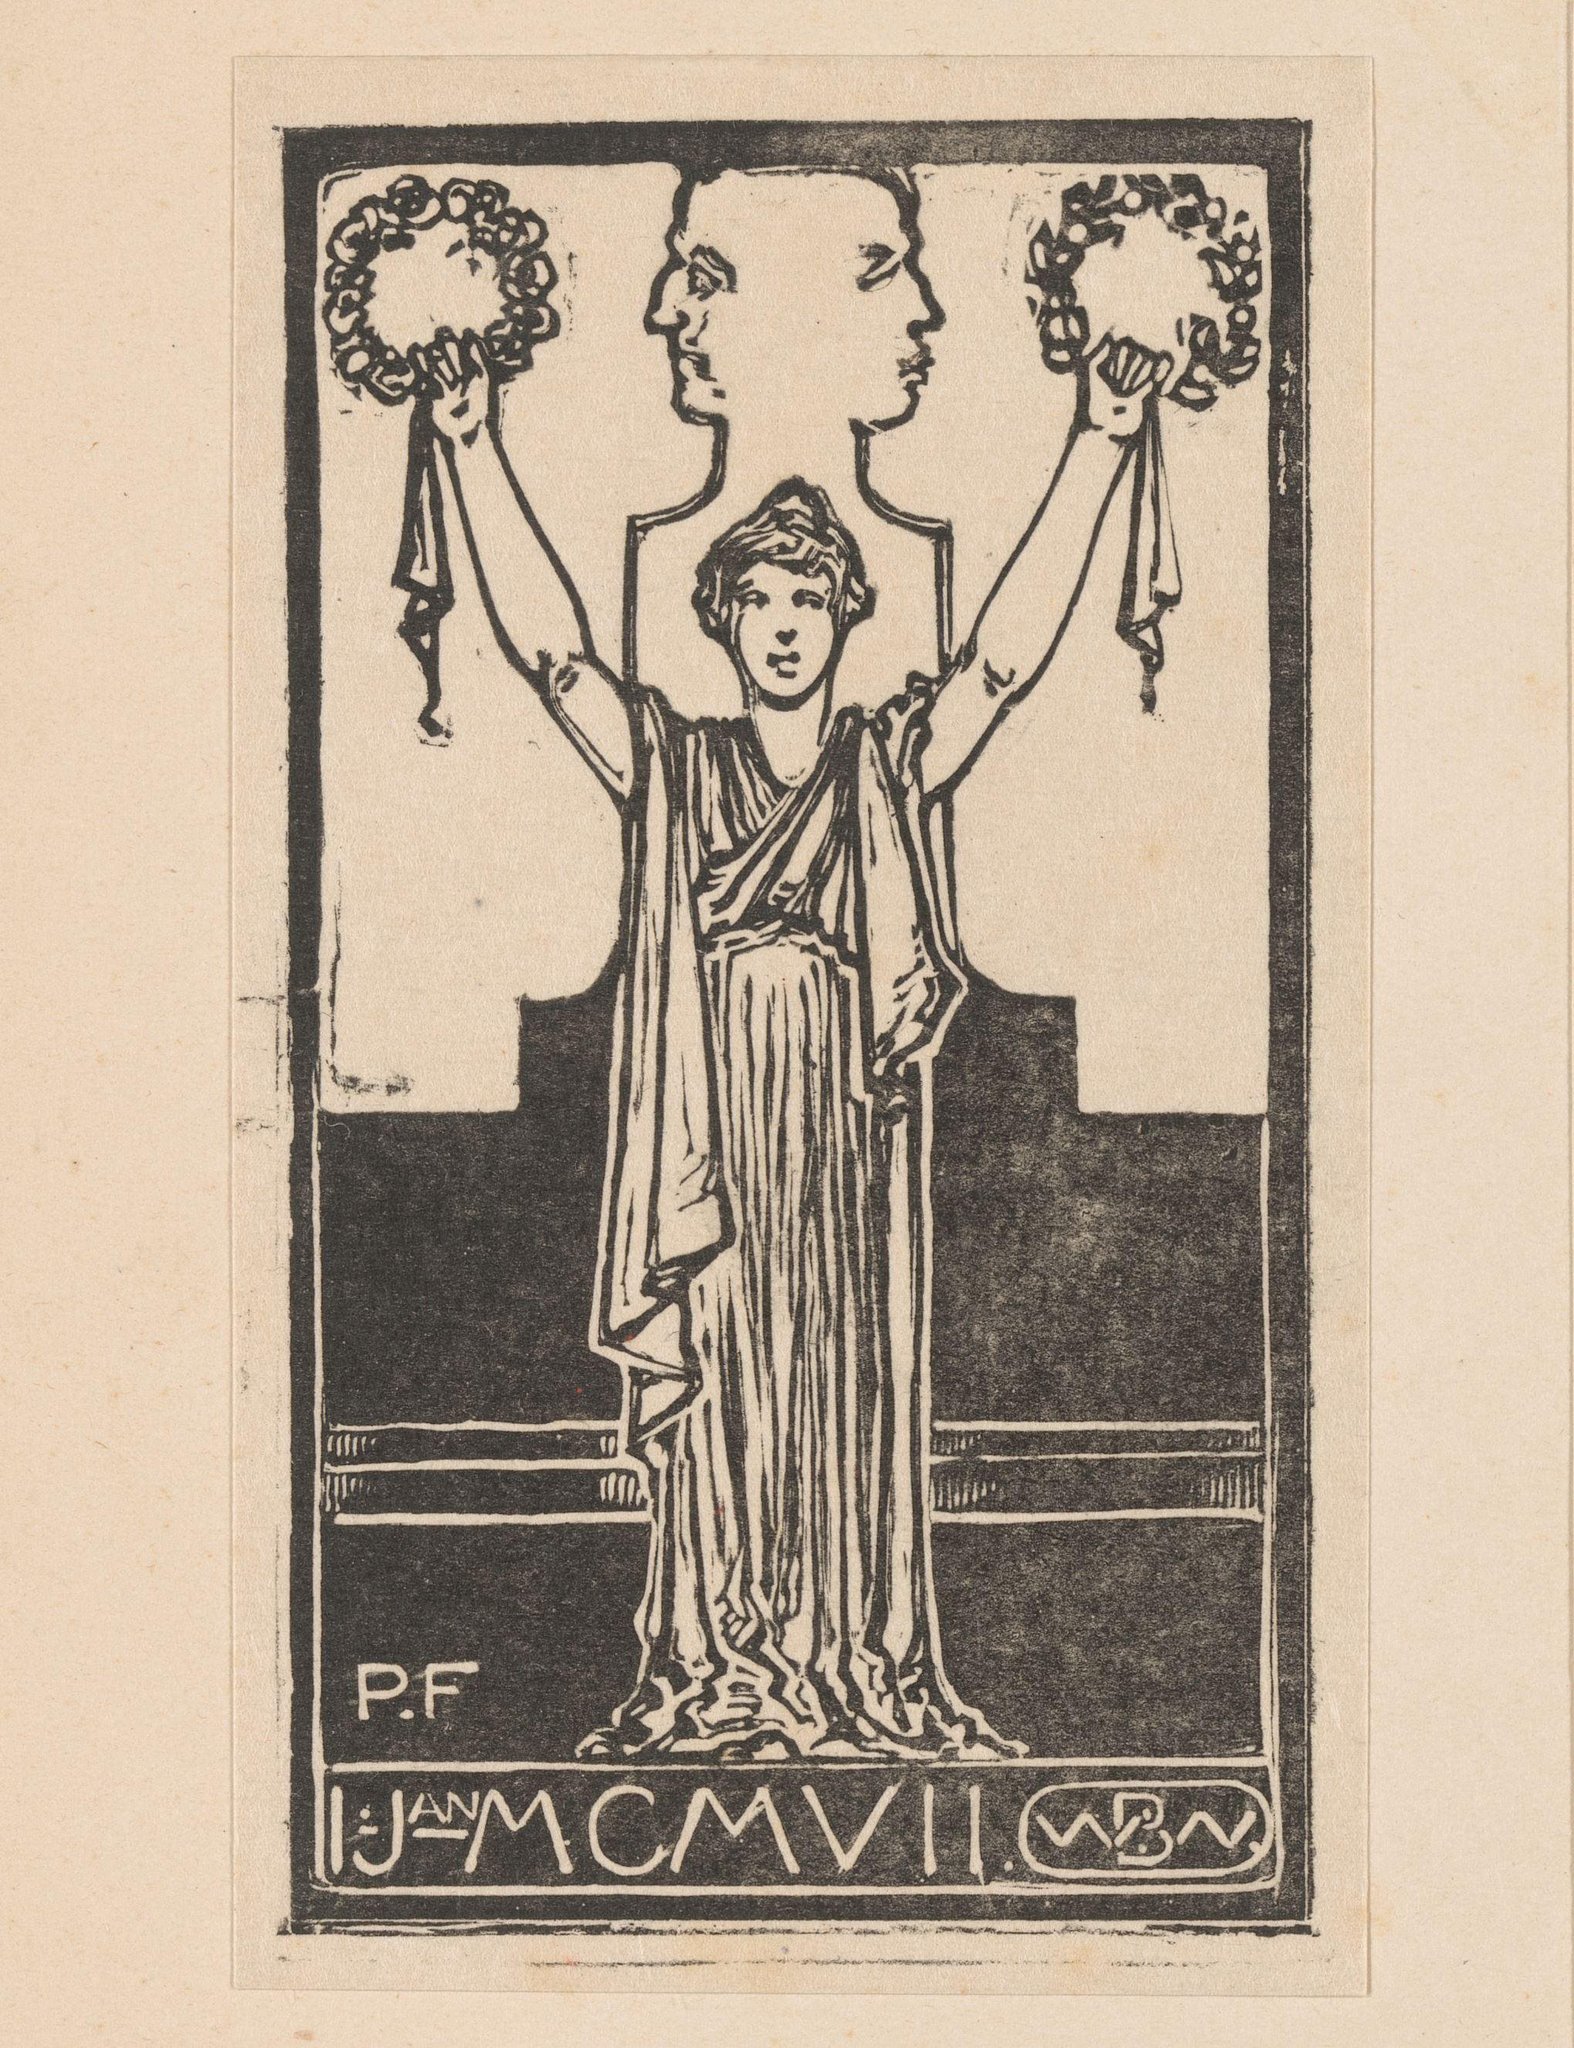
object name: print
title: Vrouw in Romeins gewaad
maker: bernard willem wierink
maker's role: draughtsman, print maker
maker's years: 1856-1939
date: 1907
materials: paper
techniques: relief print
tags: garland, wreath, (story of) the roman women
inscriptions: collector's mark: Lugt 2228, collector's mark: Lugt 2760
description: Deze prent is vermoedelijk een plaatsnede, ook al wordt in de literatuur veelal gesproken over een houtsnede. Voor zover Wierink zijn prenten in hoogdruk zelf nader heeft omschreven, heeft hij altijd de term 'plaatsnede' gebruikt.